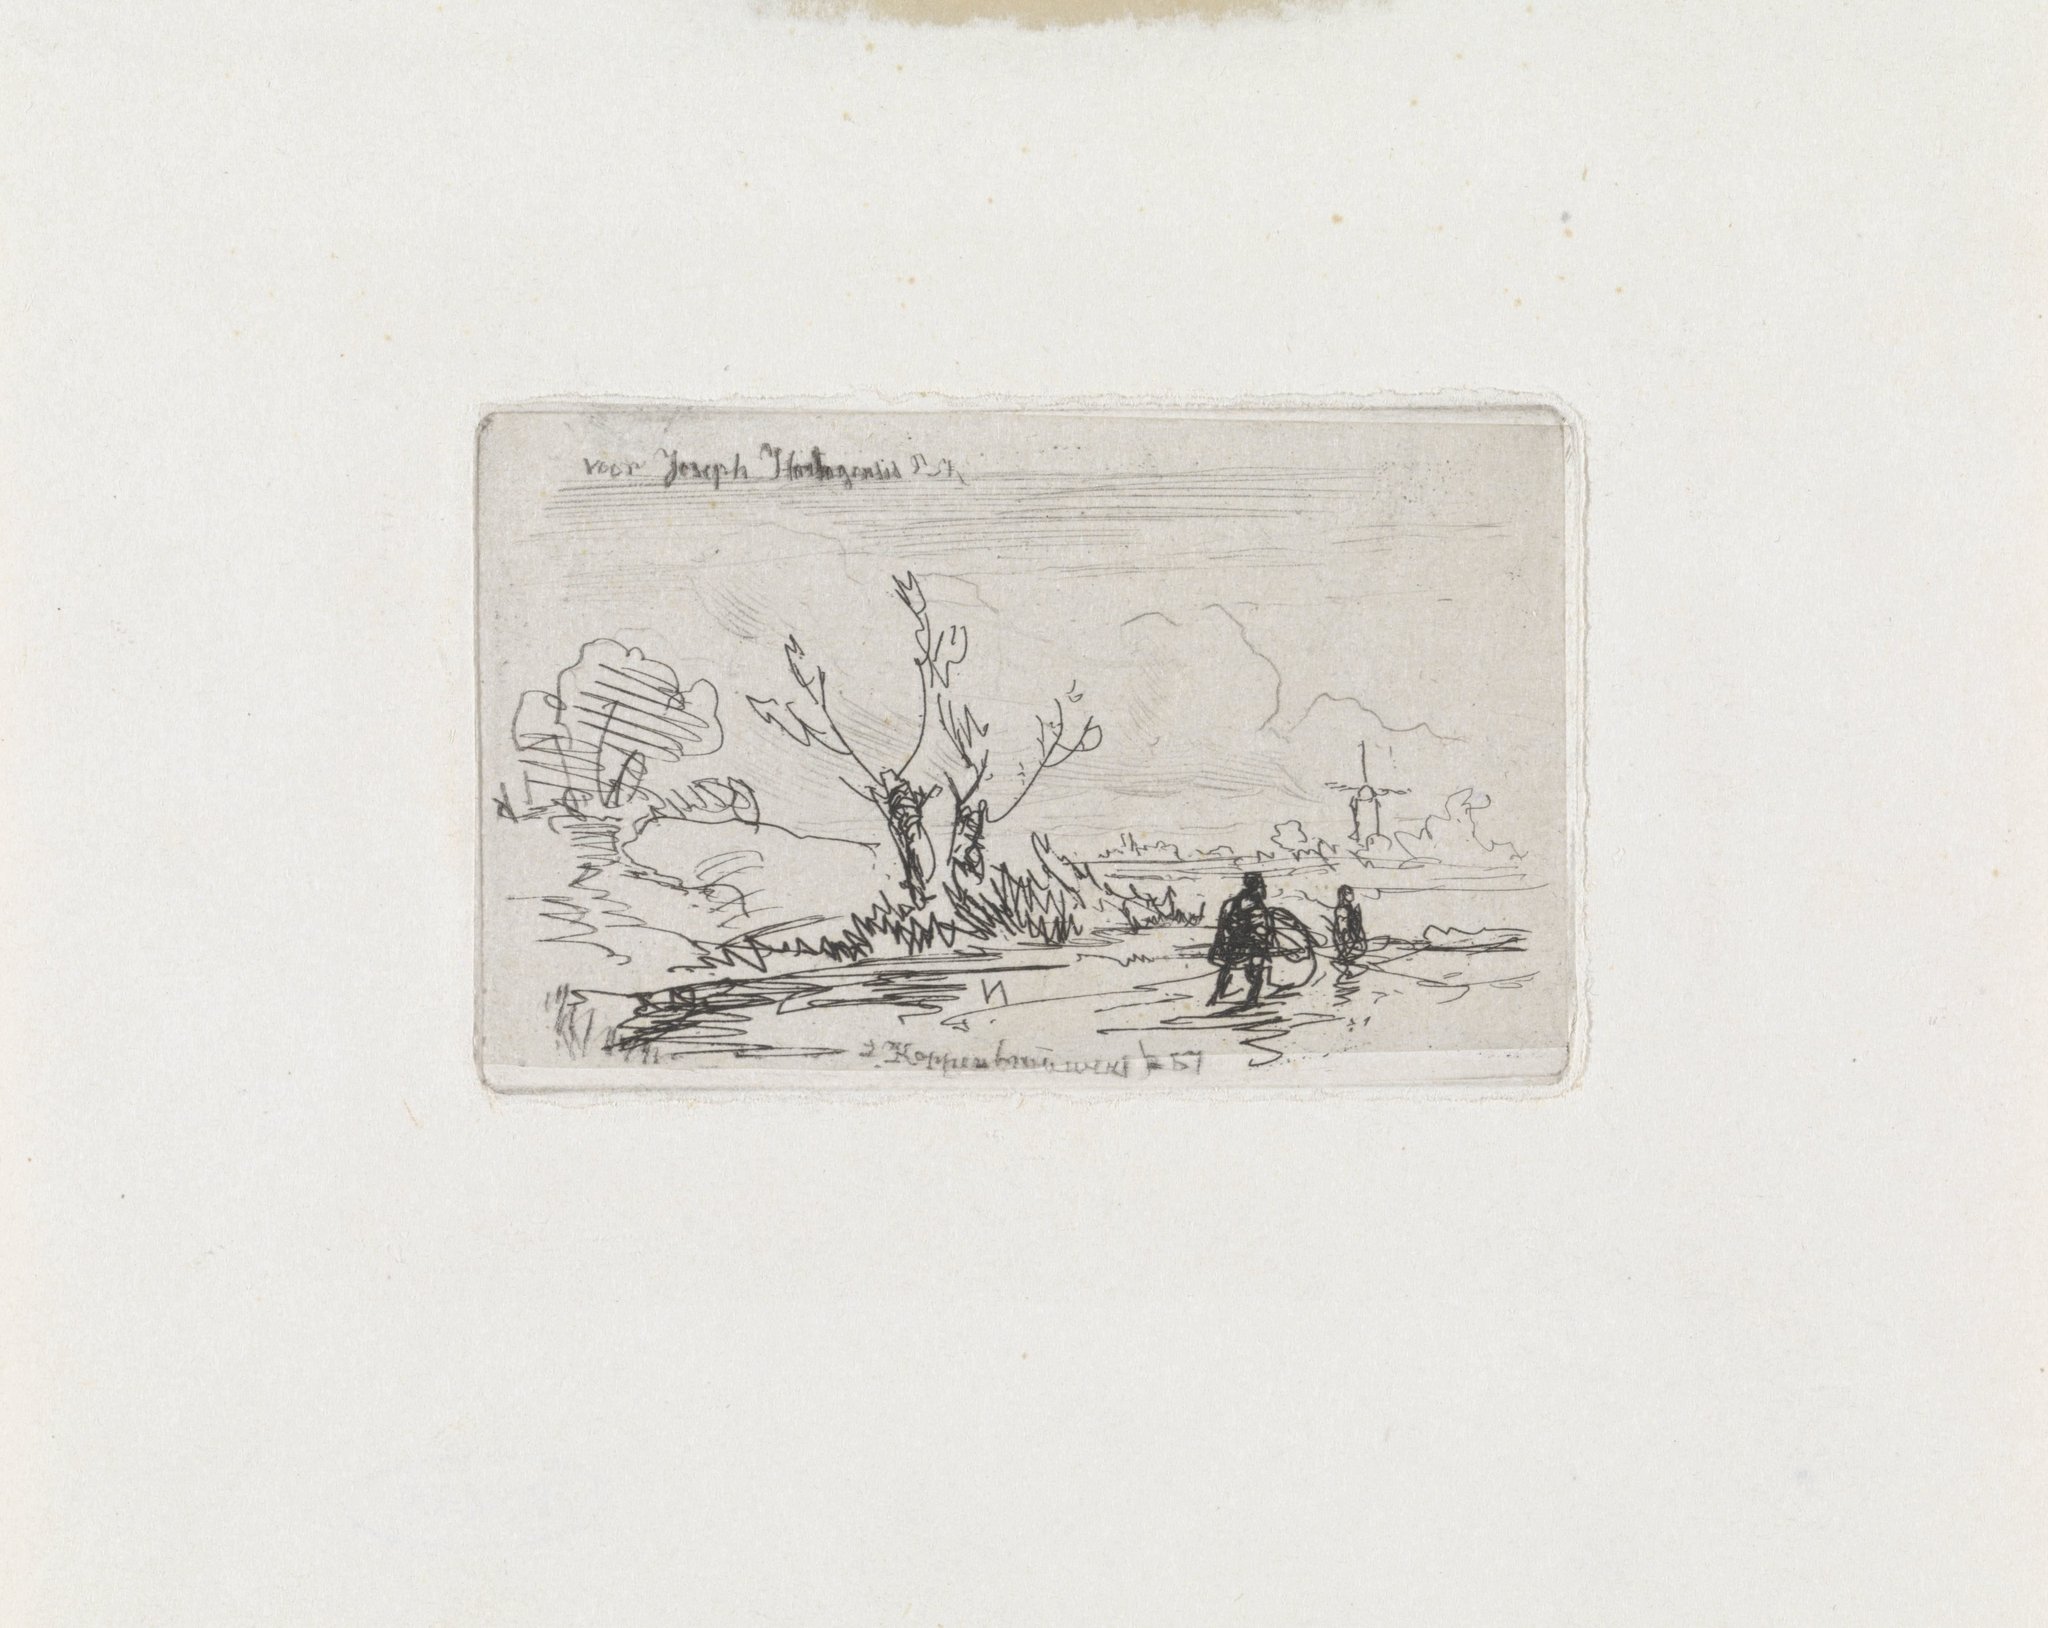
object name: print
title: Schaatsers bij knotwilgen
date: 1857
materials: paper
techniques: etching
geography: the hague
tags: skates (winter sports), trees: willow, windmill in landscape (+ city(-scape) with figures, staffage)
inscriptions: collector's mark: Lugt 2228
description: Winterlandschap met twee schaatsers op het ijs, rijdend langs twee knotwilgen. Op de achtergrond een molen.